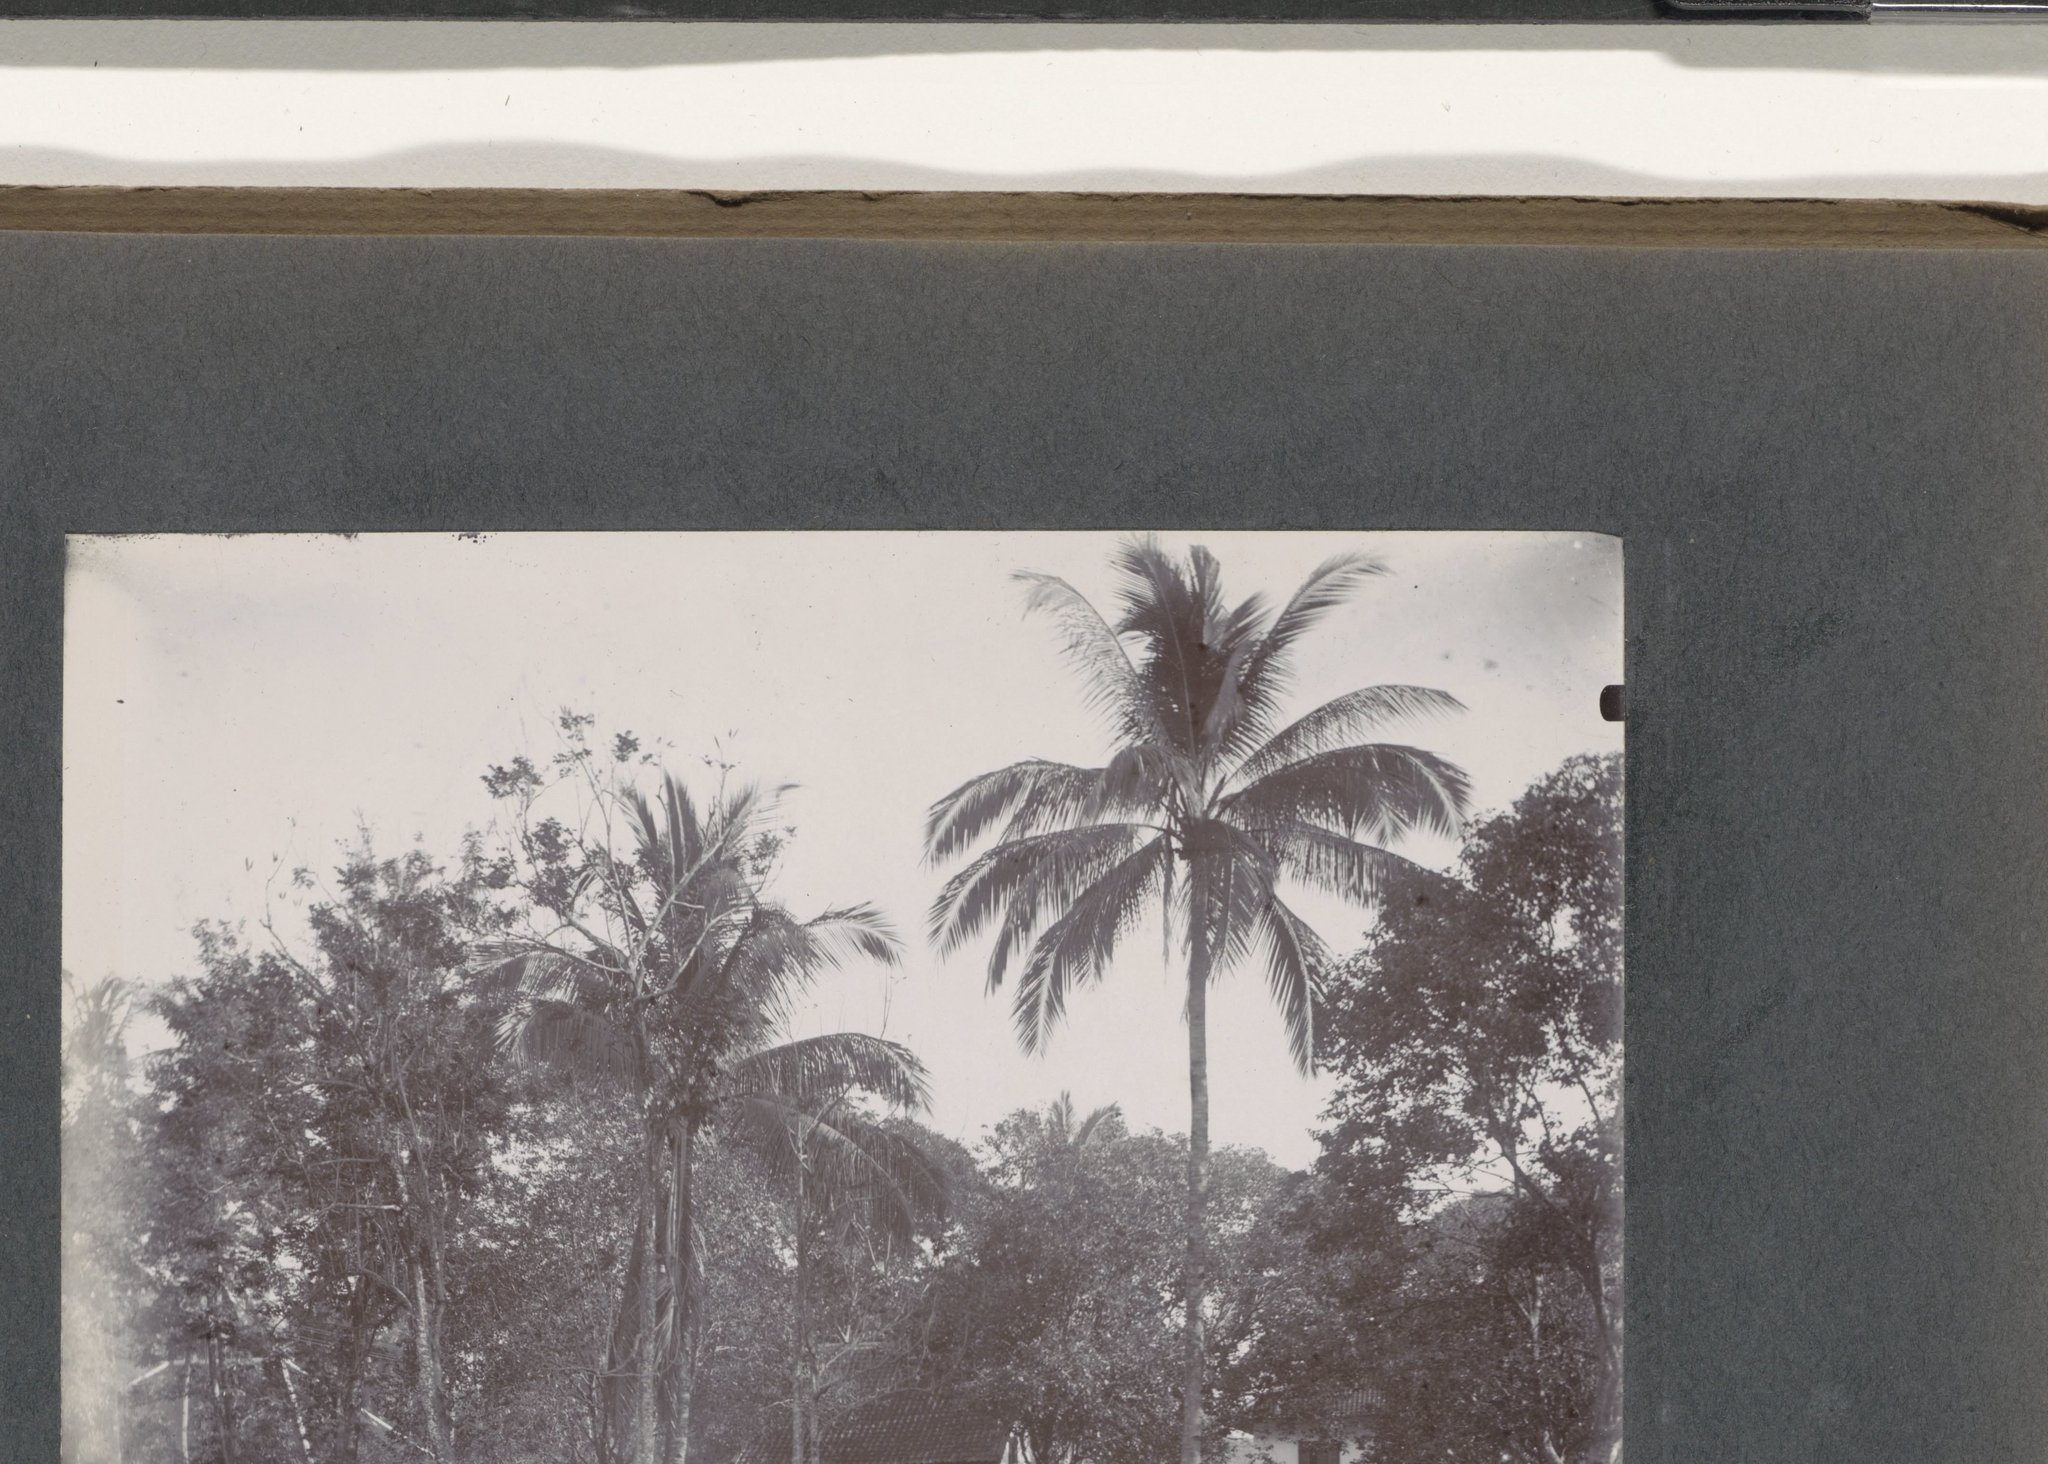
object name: photograph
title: Woonhuis en gebouwtjes onder bomen, vermoedelijk op het terrein van een ziekenhuis in Nederlands-Indië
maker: Anonymous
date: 1920-1930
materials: photographic support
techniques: gelatin silver print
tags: trees, rural housing, e.g. country-house, villa, cottage, hospital, trees: palm-tree, nursing, tending the sick, dutch east indies, the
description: Onderdeel van fotoalbum van een ziekenhuis in Nederlands-Indië.